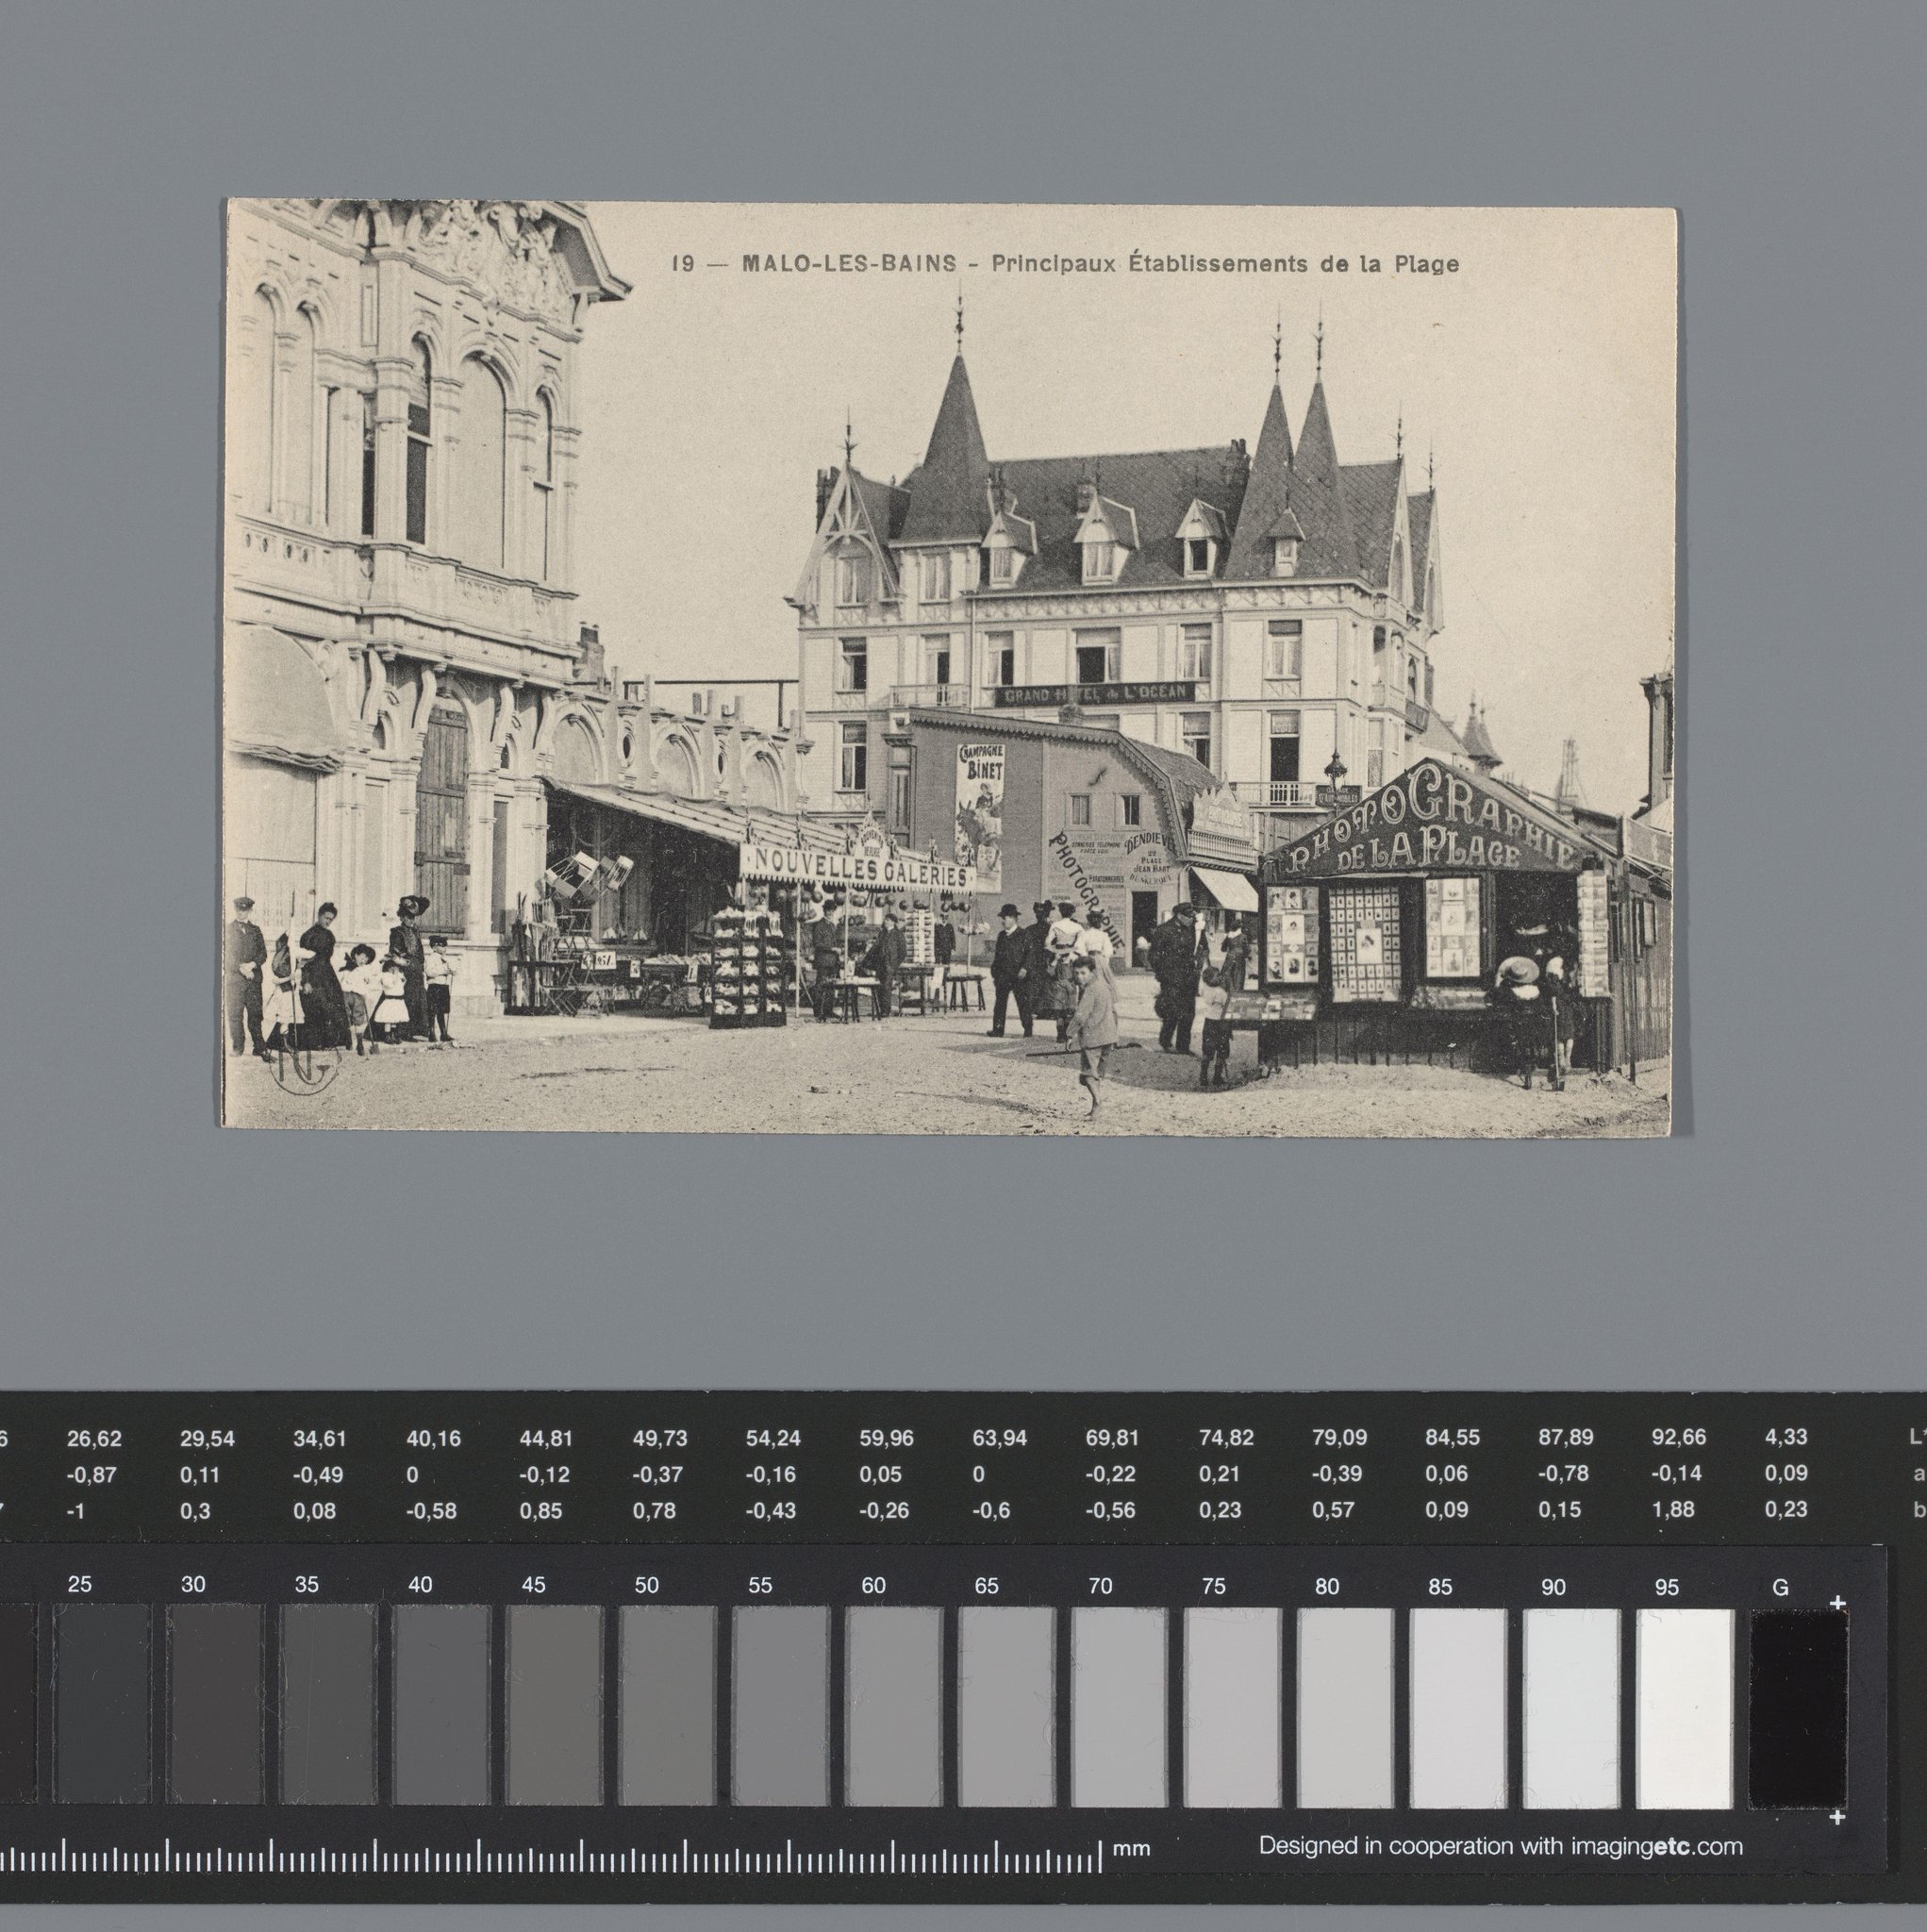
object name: ansichtkaart, prentbriefkaart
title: Place du Kursaal, Malo-les-Bains, Duinkerke met fotoatelier en Hôtel de l’Océan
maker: Anonymous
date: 1900-1920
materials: paper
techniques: photograph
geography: dunkirk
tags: duinkerke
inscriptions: inscription: ‘19 — MALO-LES-BAINS – Principaux Établissements de la Plage’, inscription: ‘CARTE POSTALE / La Correspondance au recto n’est pas acceptee par tous les pays éstrangers. (Se renseigner á la Poste.) / Correspondance / Adresse’